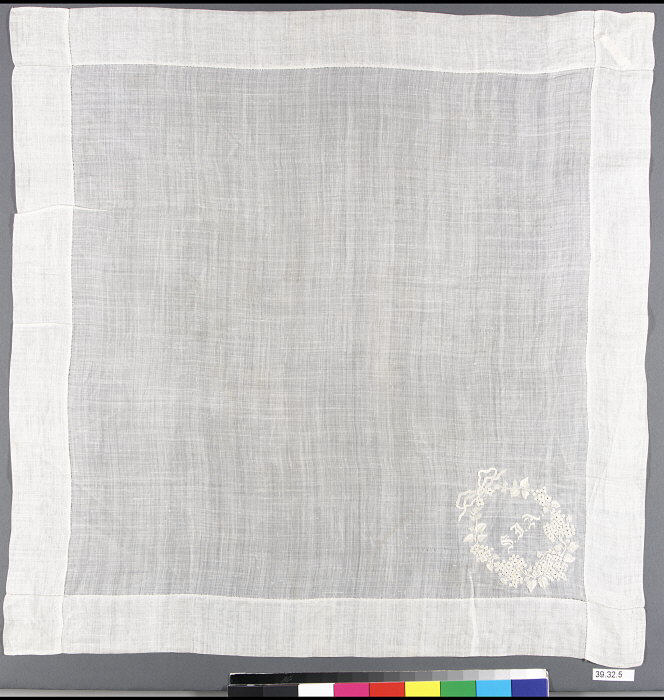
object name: handkerchief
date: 1801-1900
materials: cotton